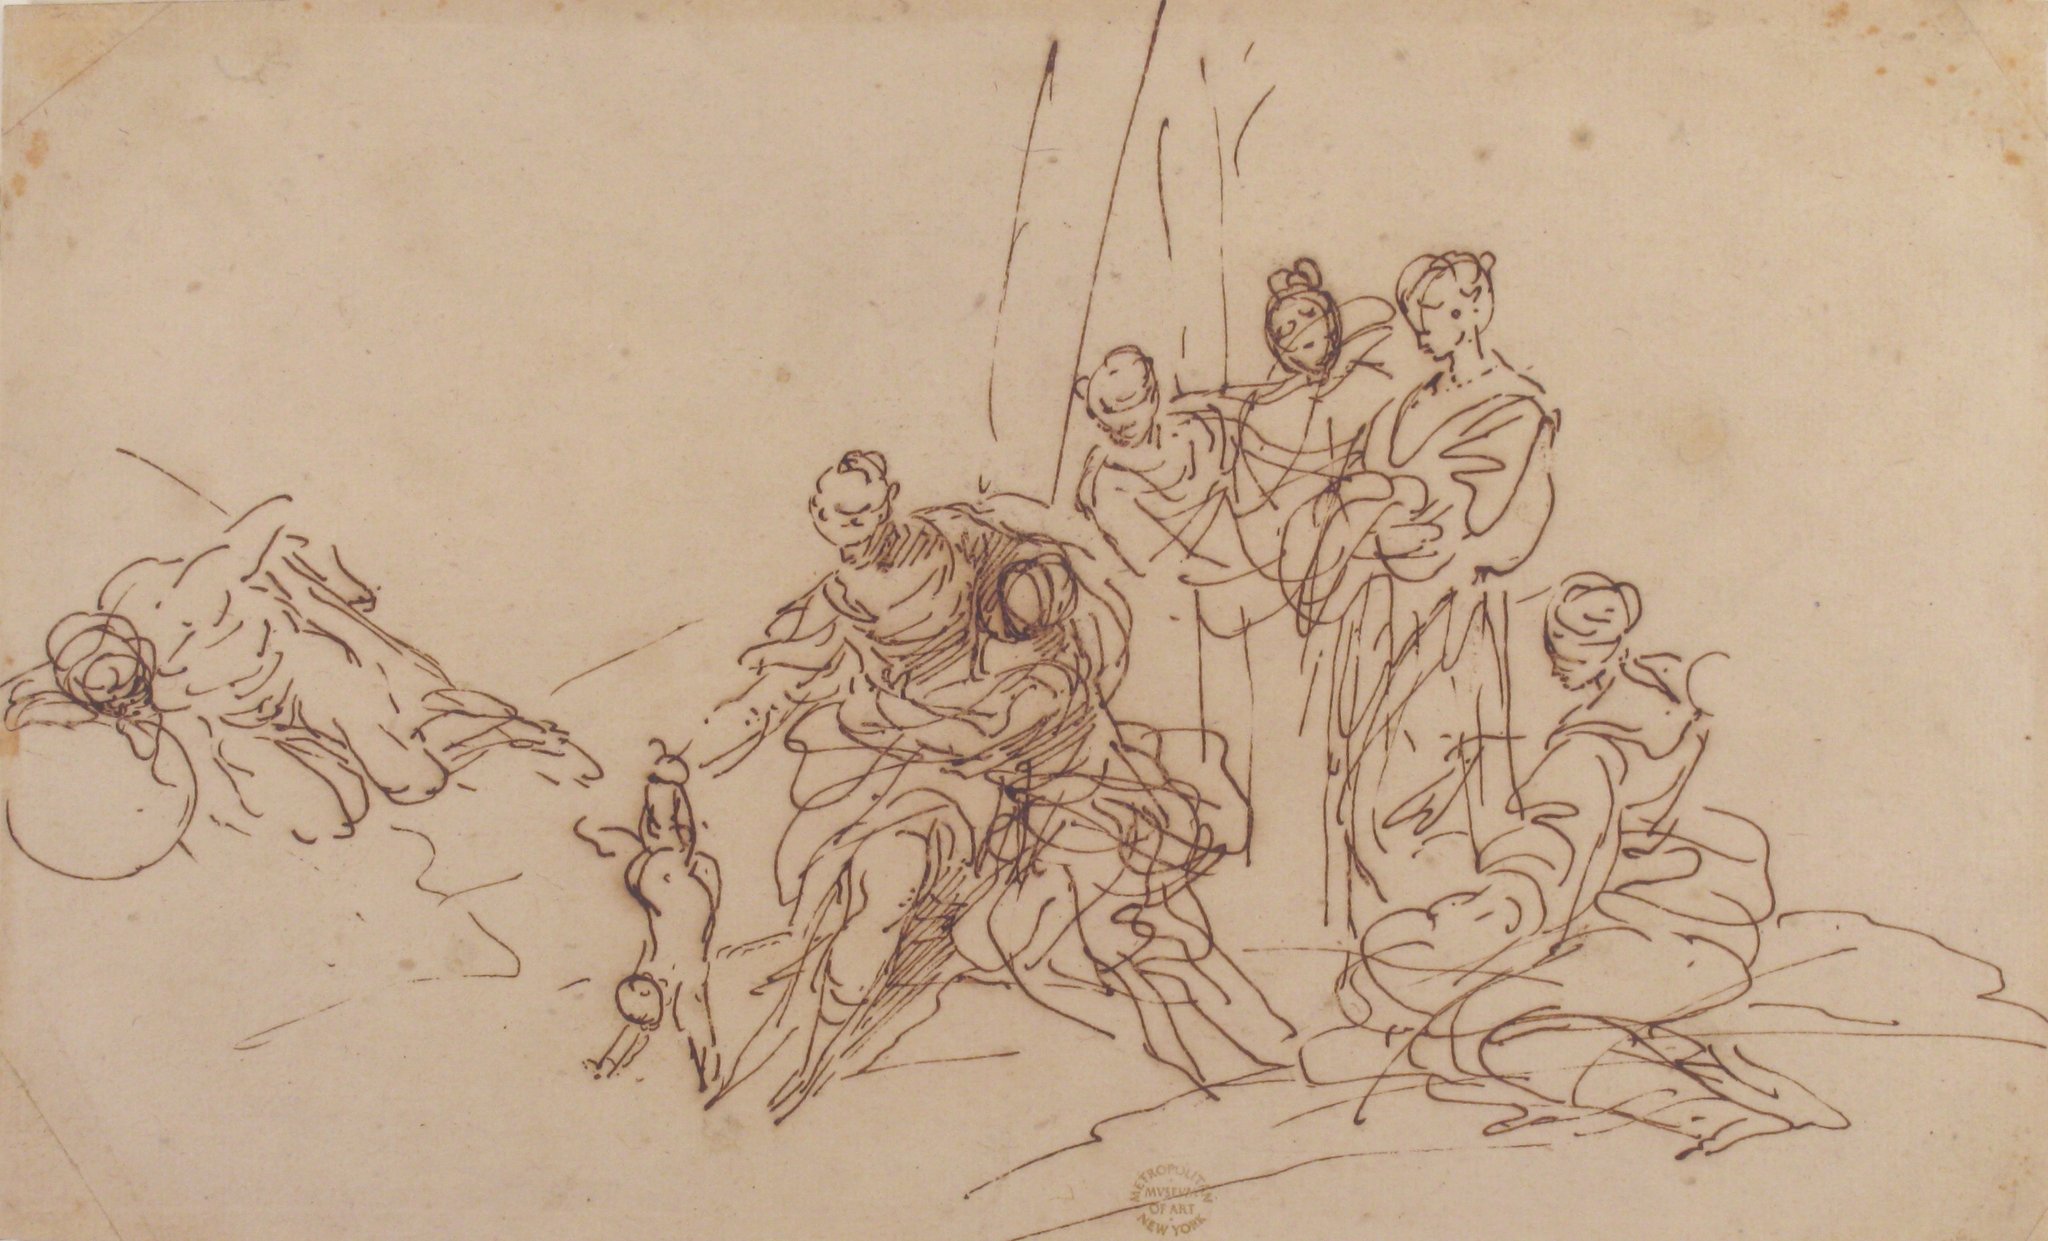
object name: drawing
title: Thetis Dipping the Infant Achilles into the Waters of the Styx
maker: donato creti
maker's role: artist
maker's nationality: italian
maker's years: 1671-1749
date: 1671-1749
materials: ink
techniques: pen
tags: infants,men,women,achilles